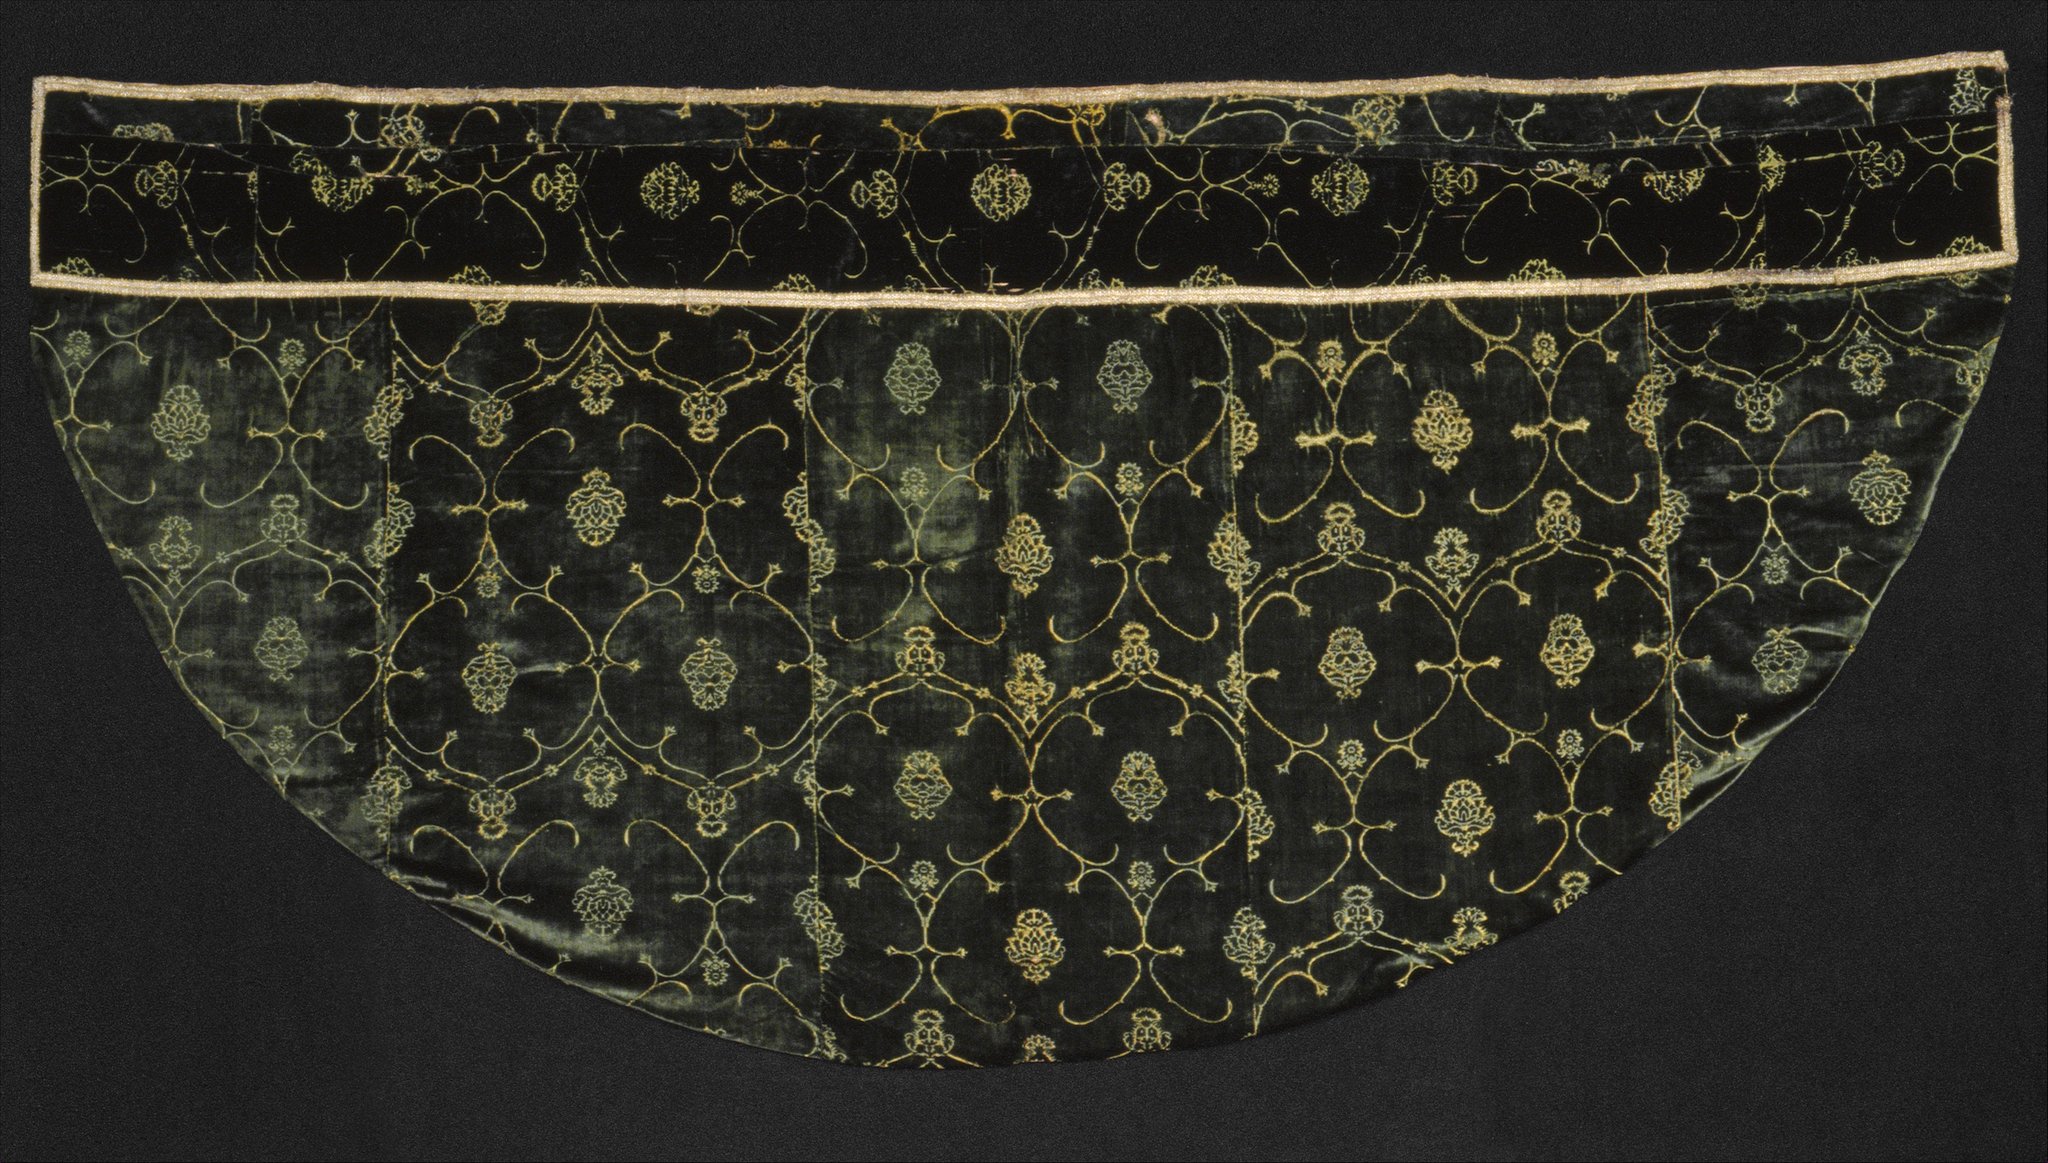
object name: cope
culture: italian or spanish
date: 1434-1466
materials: silk, velvet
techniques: cutting